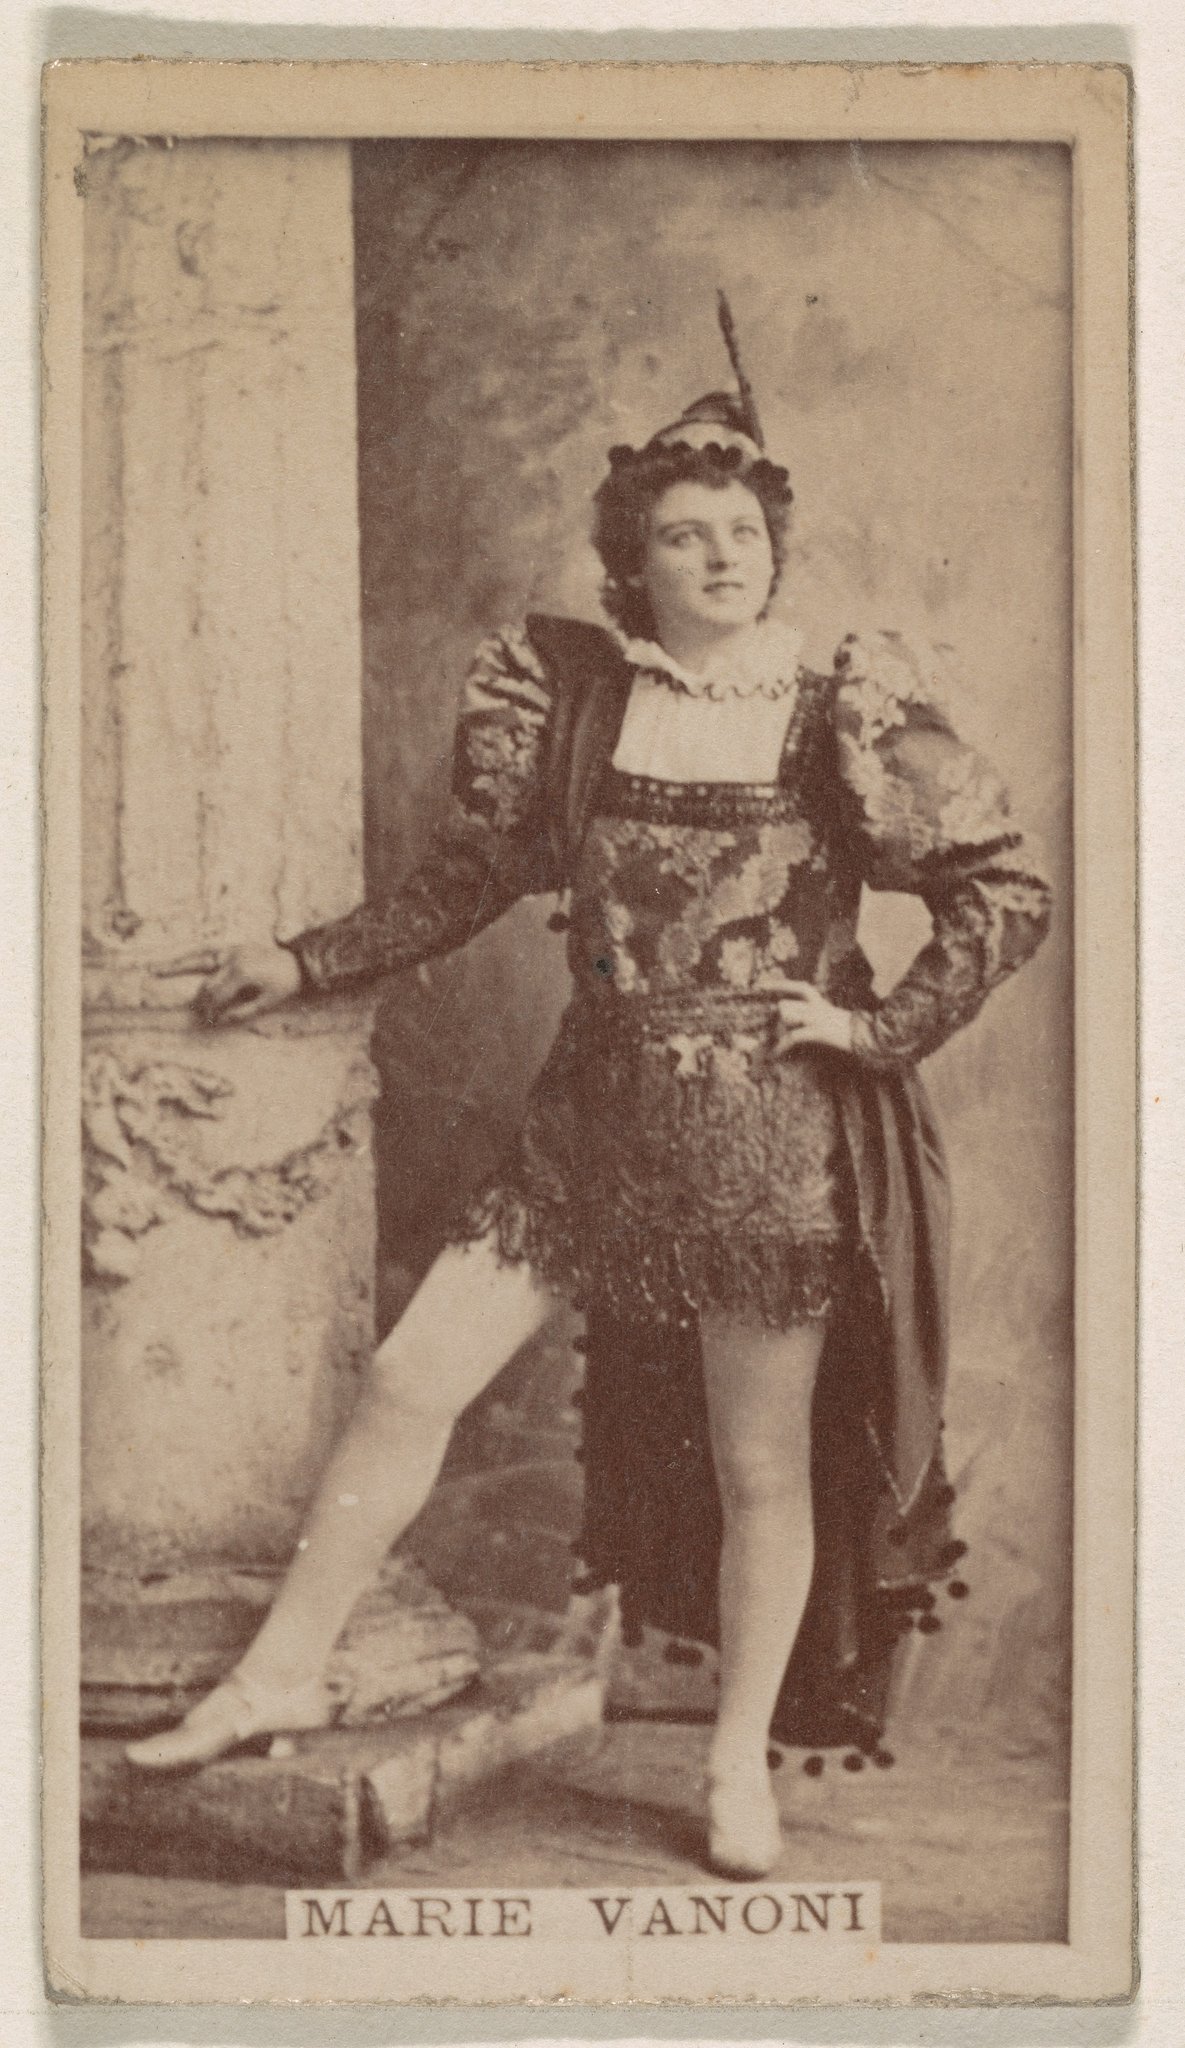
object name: photograph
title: Marie Vanoni, from the Actresses series (N245) issued by Kinney Brothers to promote Sweet Caporal Cigarettes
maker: kinney brothers tobacco company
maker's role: publisher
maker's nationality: american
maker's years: 1869-2011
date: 1890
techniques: albumen silver print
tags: portraits,women,actresses